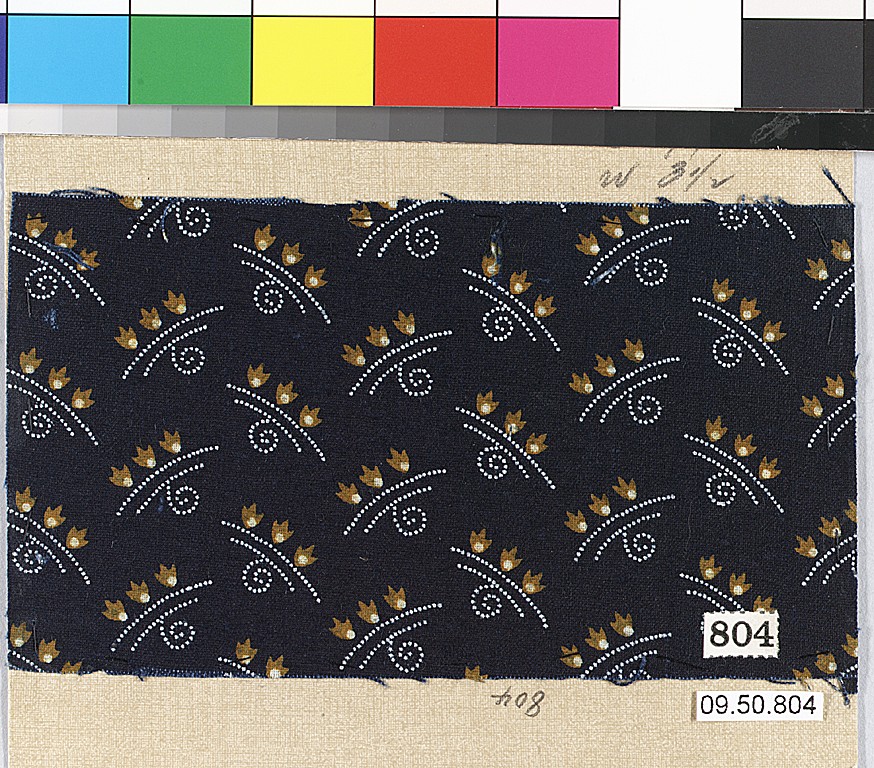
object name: piece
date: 1801-1900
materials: cotton